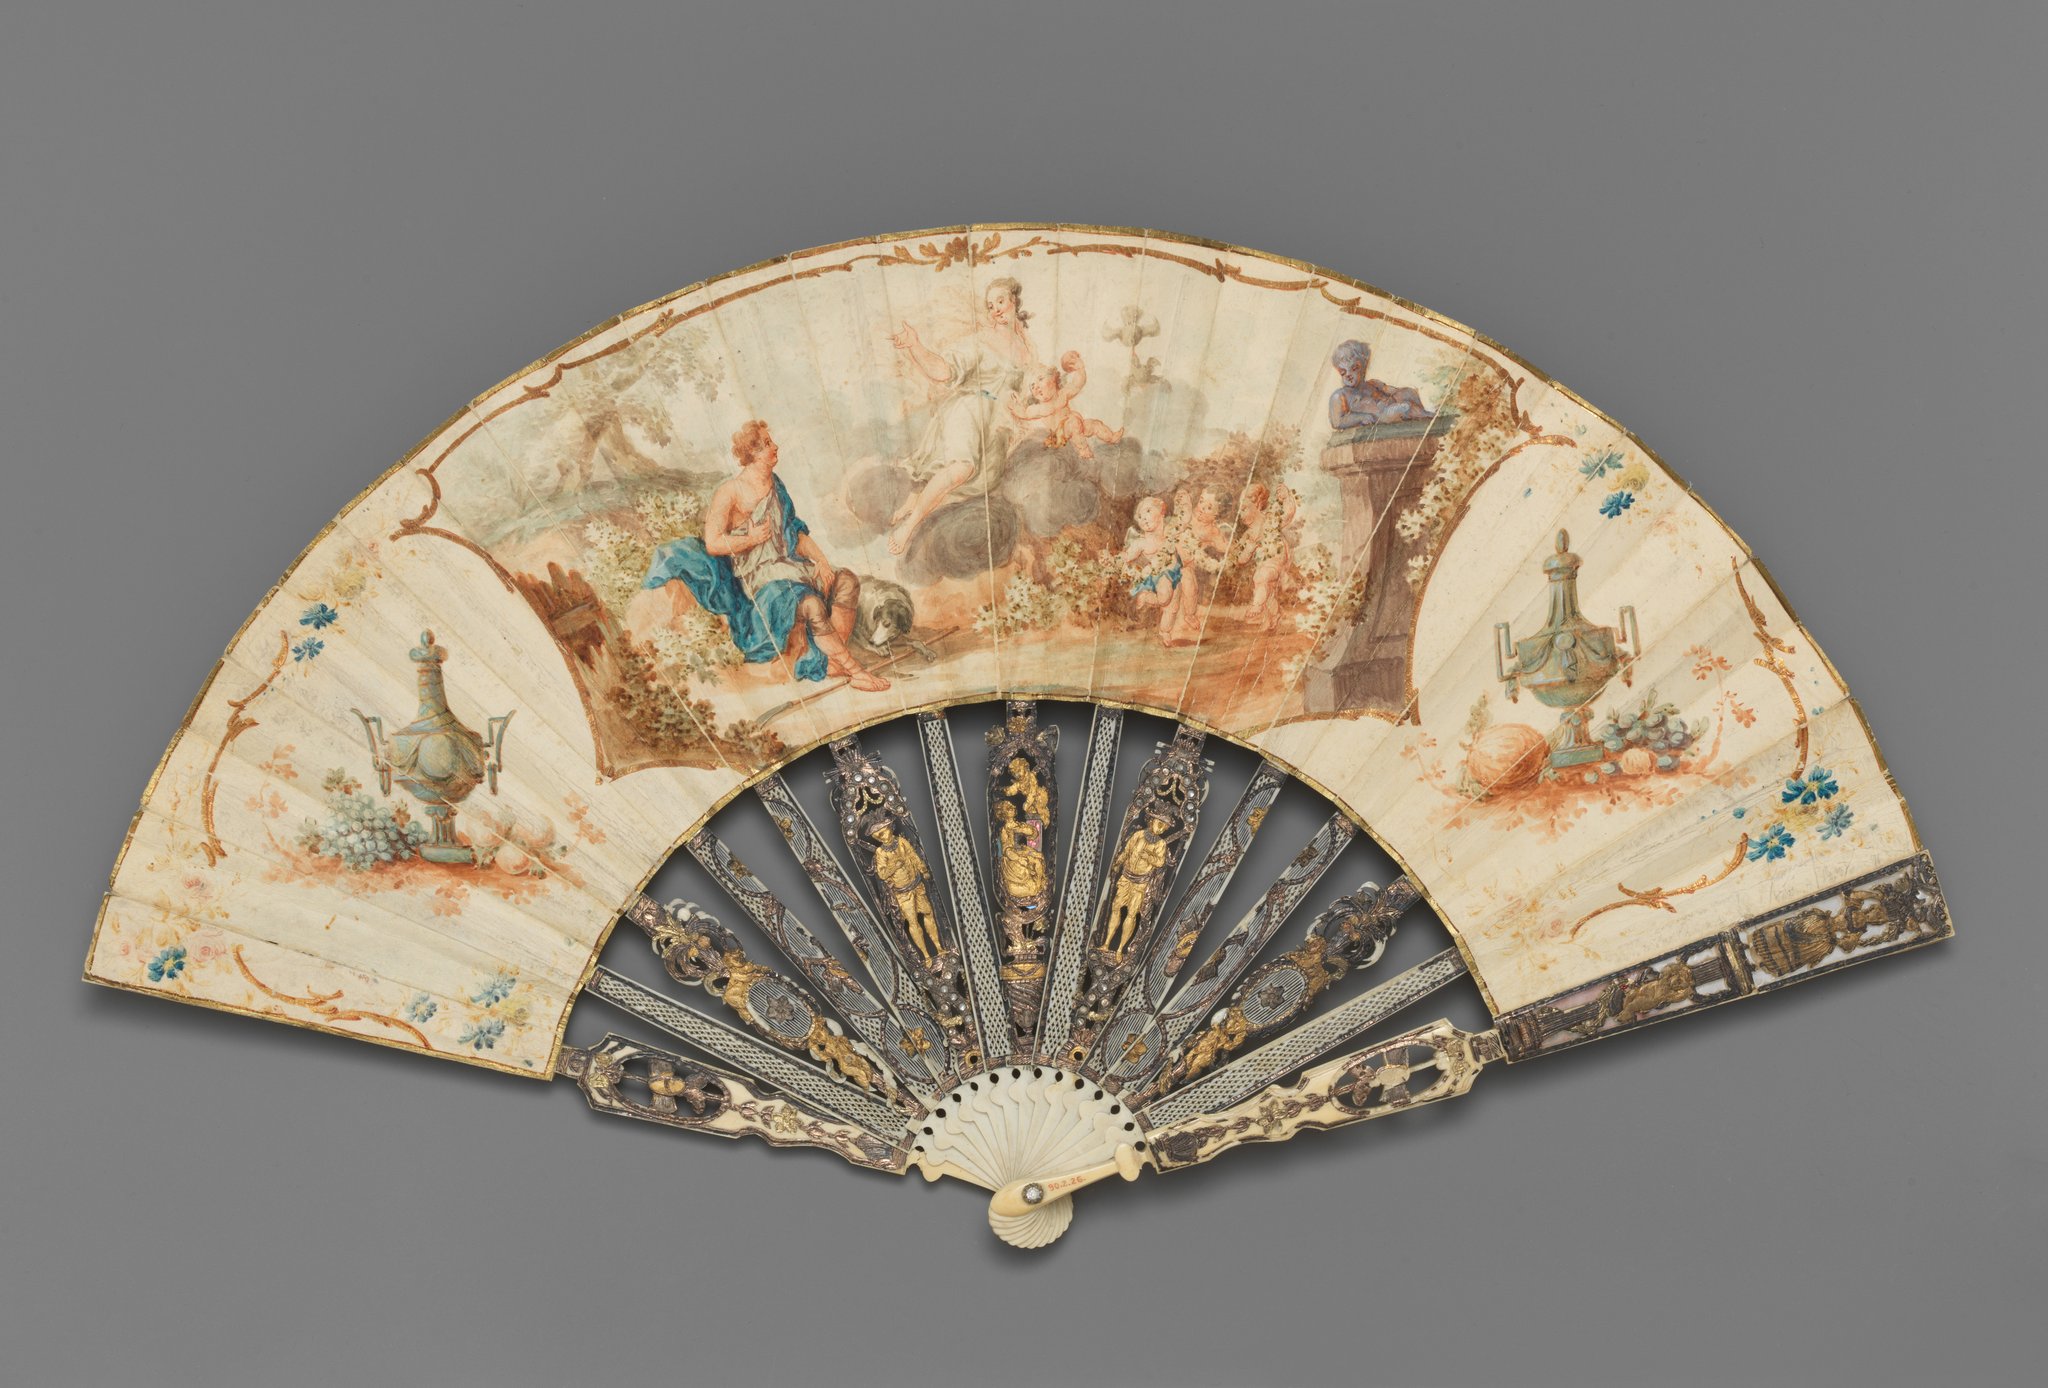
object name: fan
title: Fan depicting Venus appearing to Adonis (?)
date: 1760-1790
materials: foil, glass, ivory, metal, mother of pearl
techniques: carving, painting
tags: men,women,putti,dogs